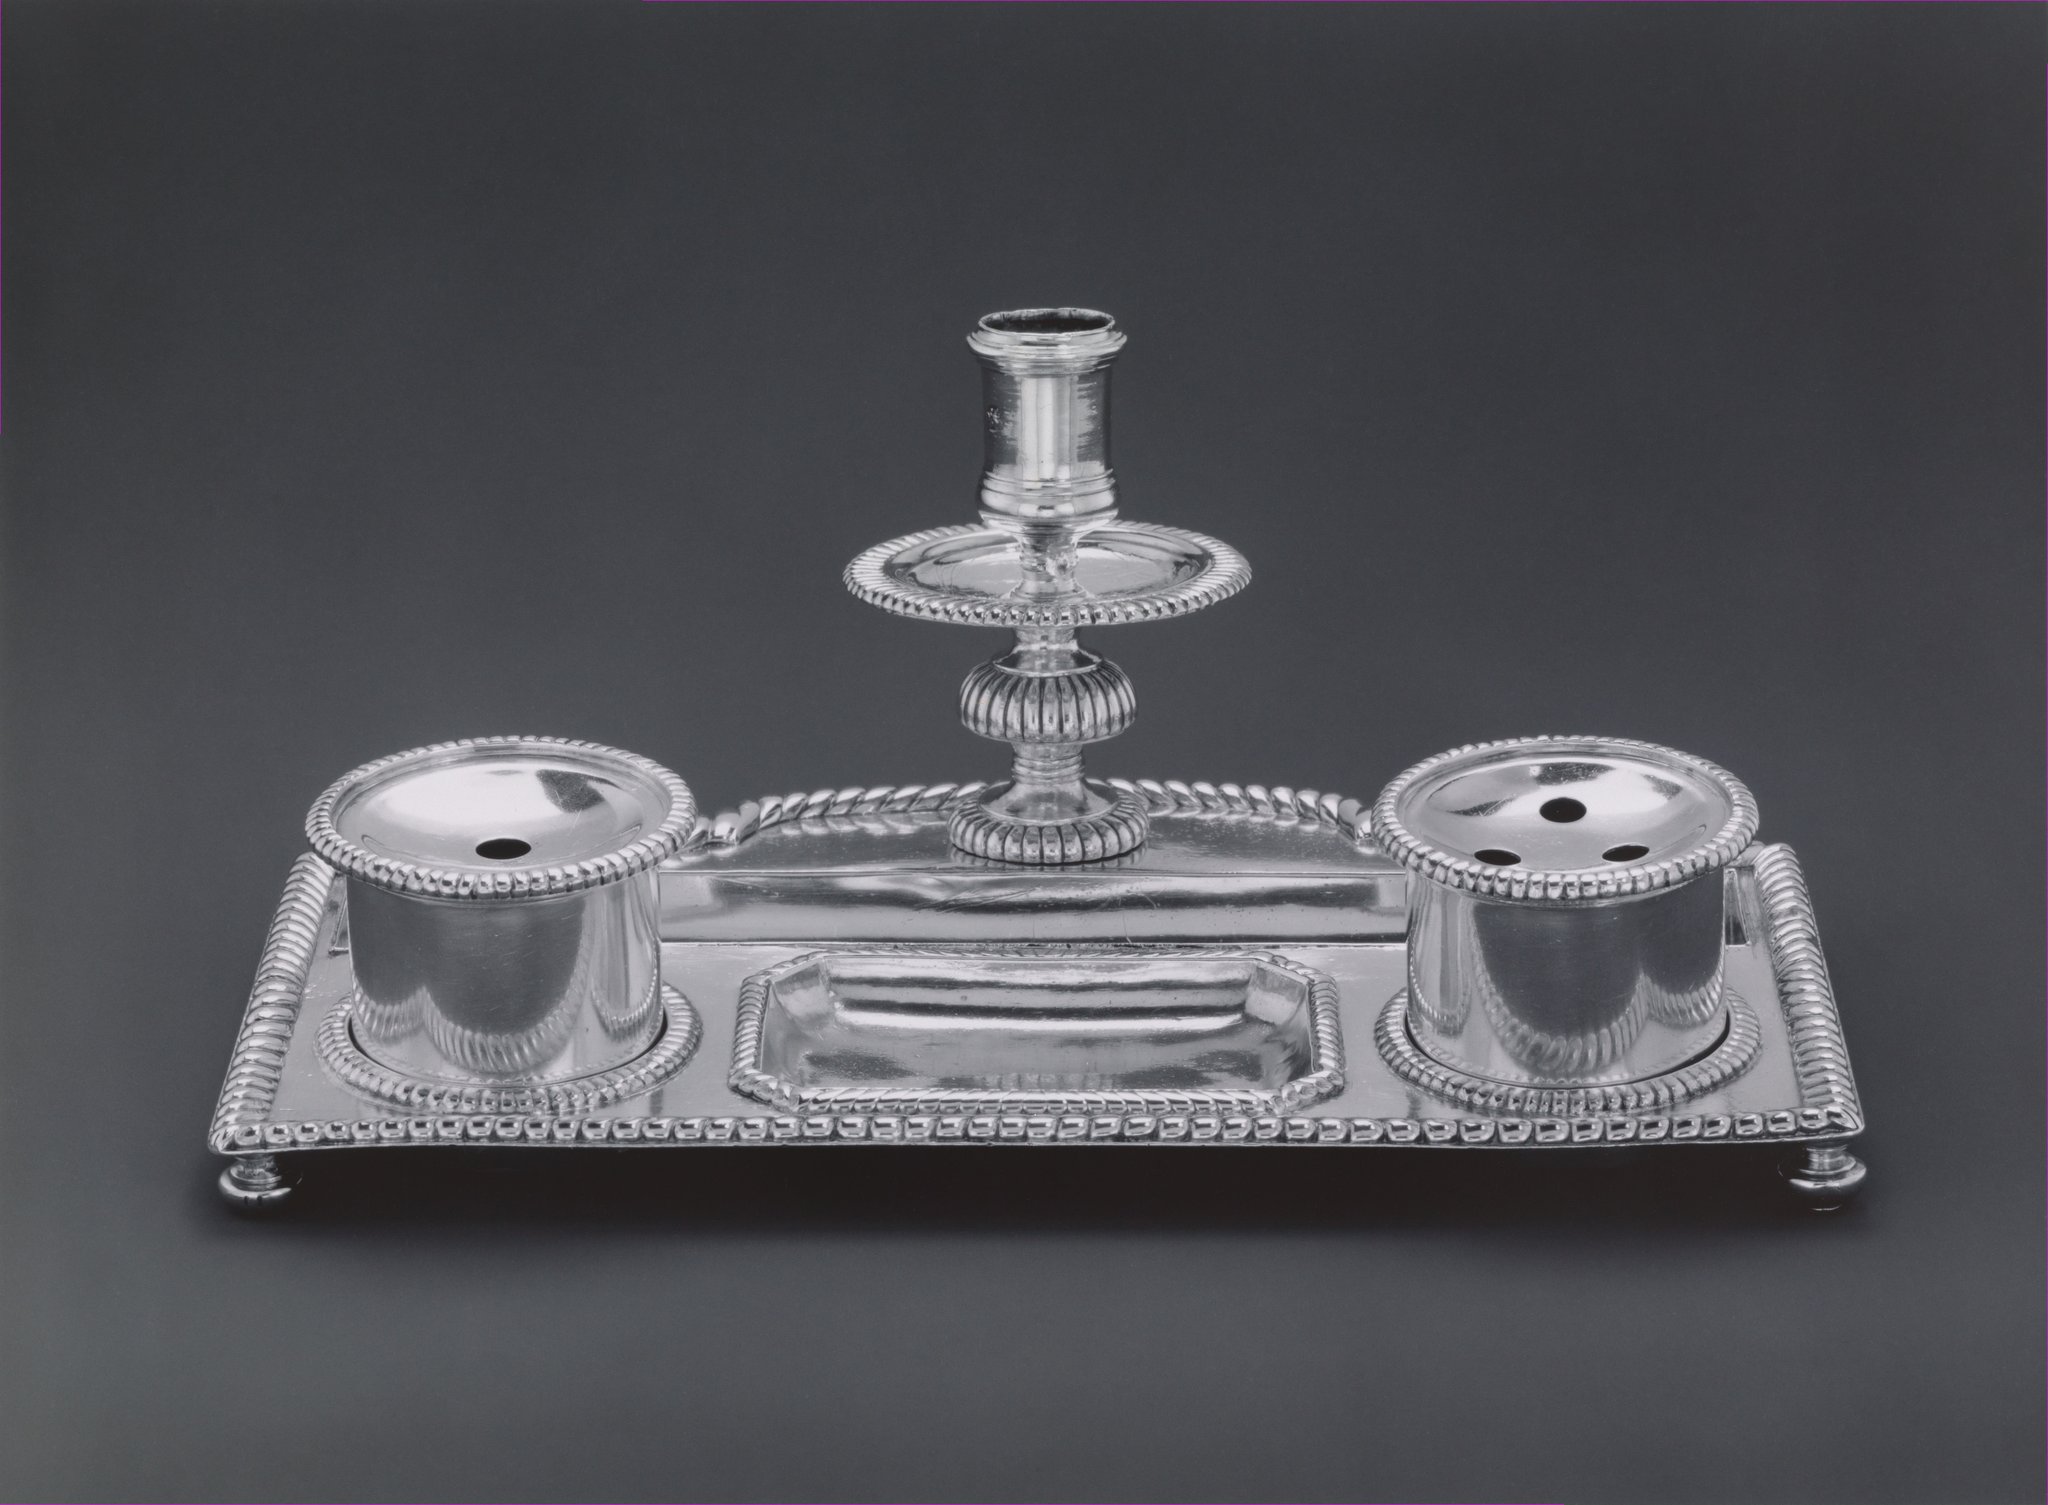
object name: inkstand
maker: peter harache i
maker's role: maker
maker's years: 1594-1694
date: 1690-1691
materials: silver